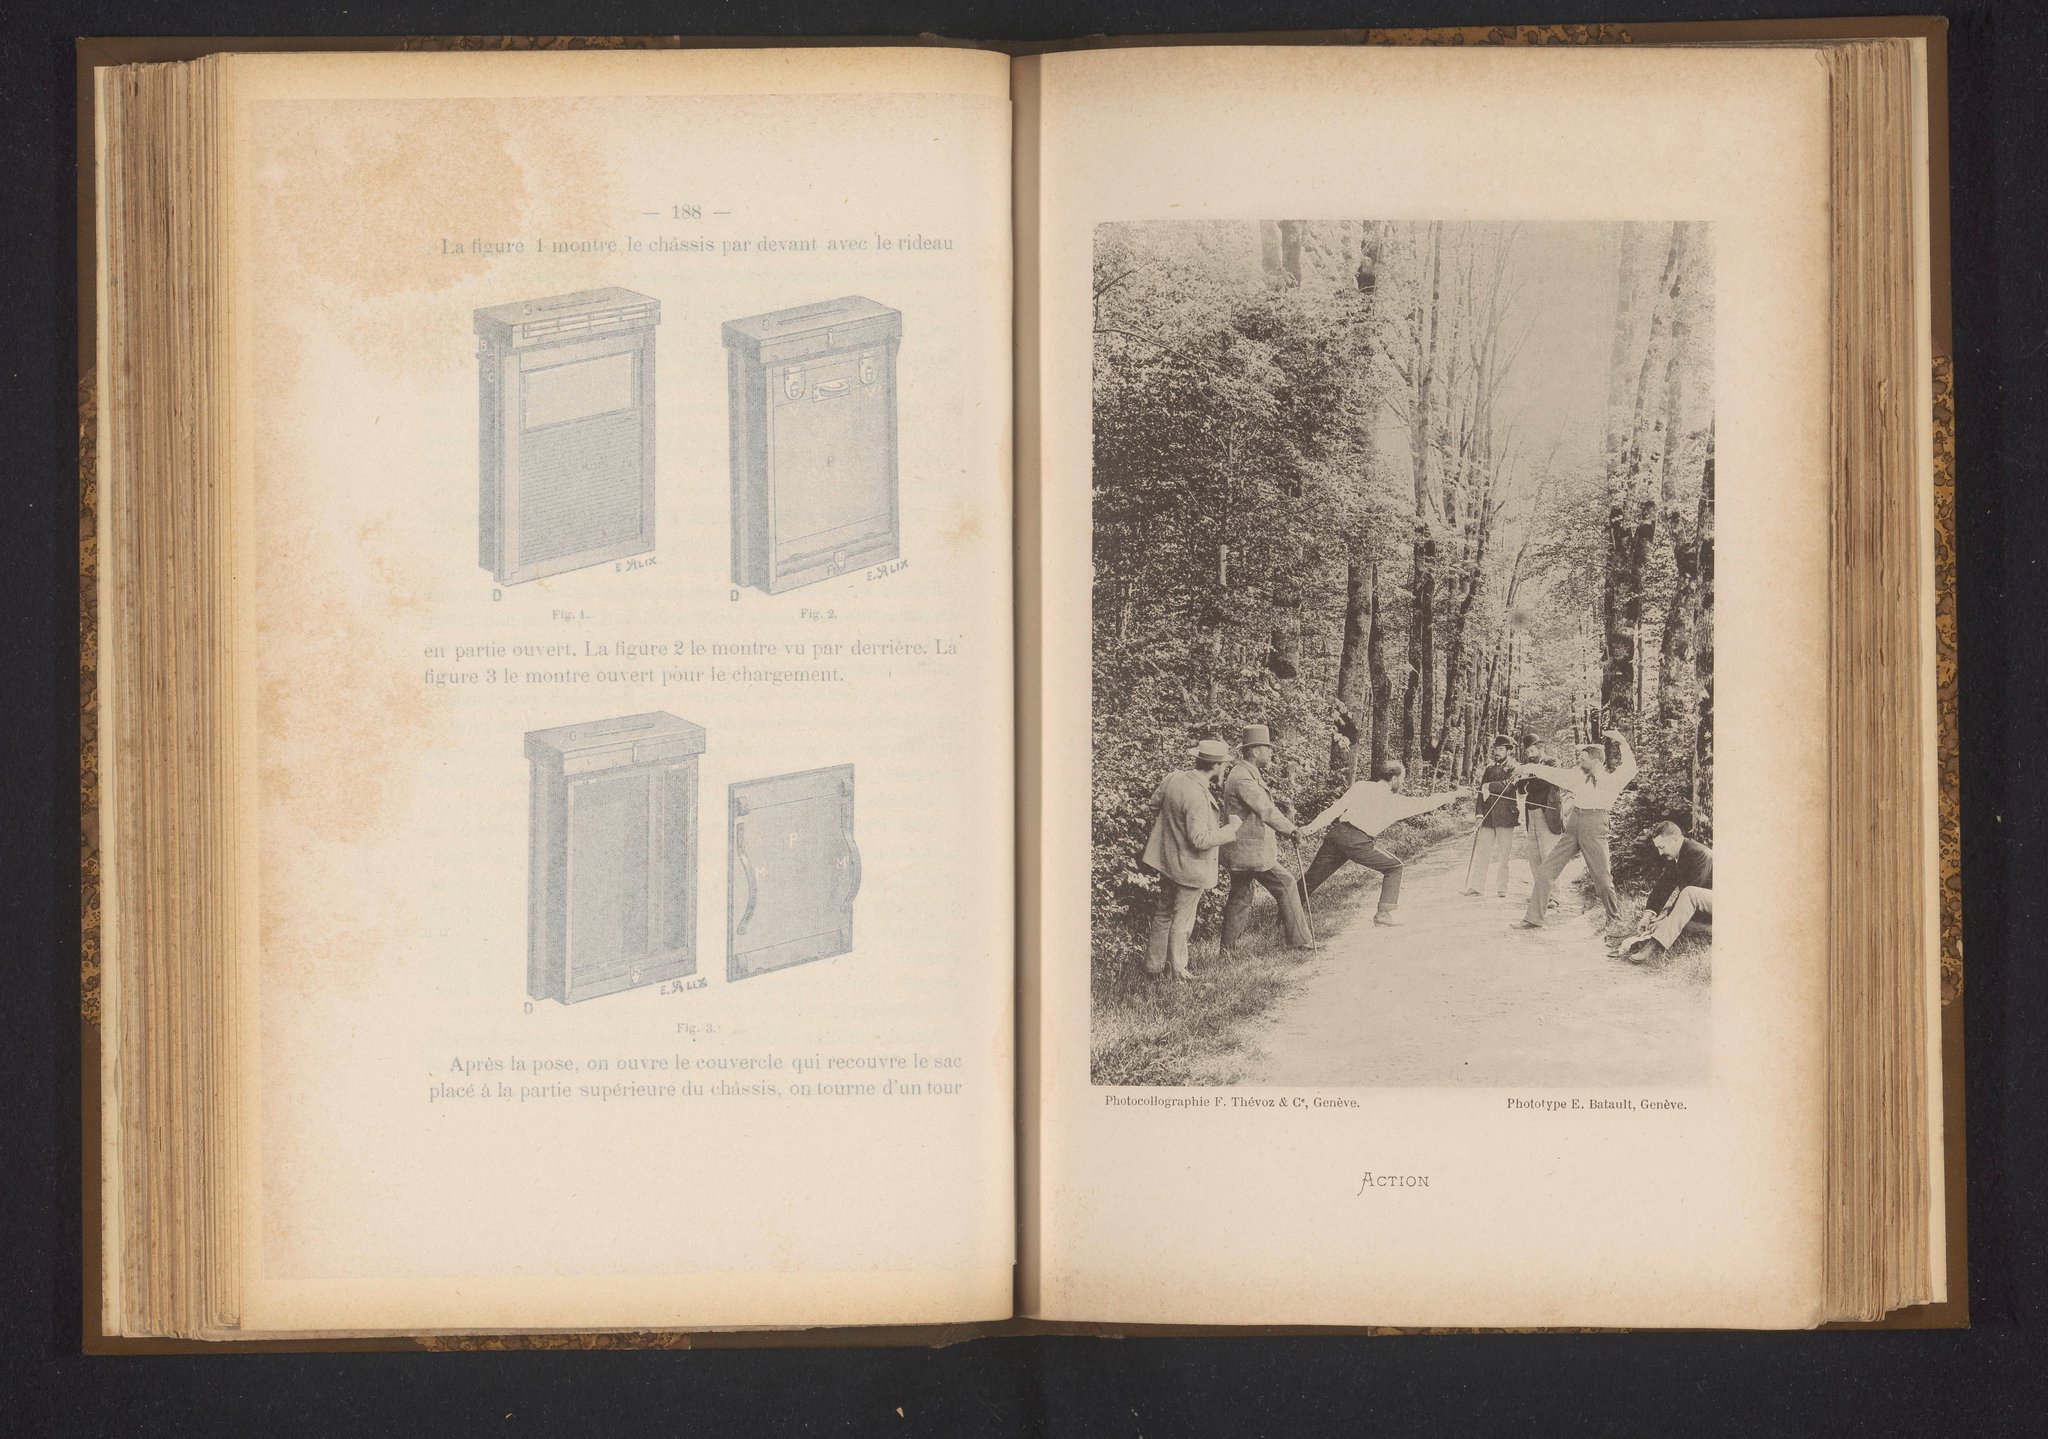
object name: page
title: Action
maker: e. batault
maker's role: maker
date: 1888-1893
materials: paper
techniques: photograph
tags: edifice, e.g.: public building, department store - aa - civic architecture: inside, lighting; lamps, fencing (sport)